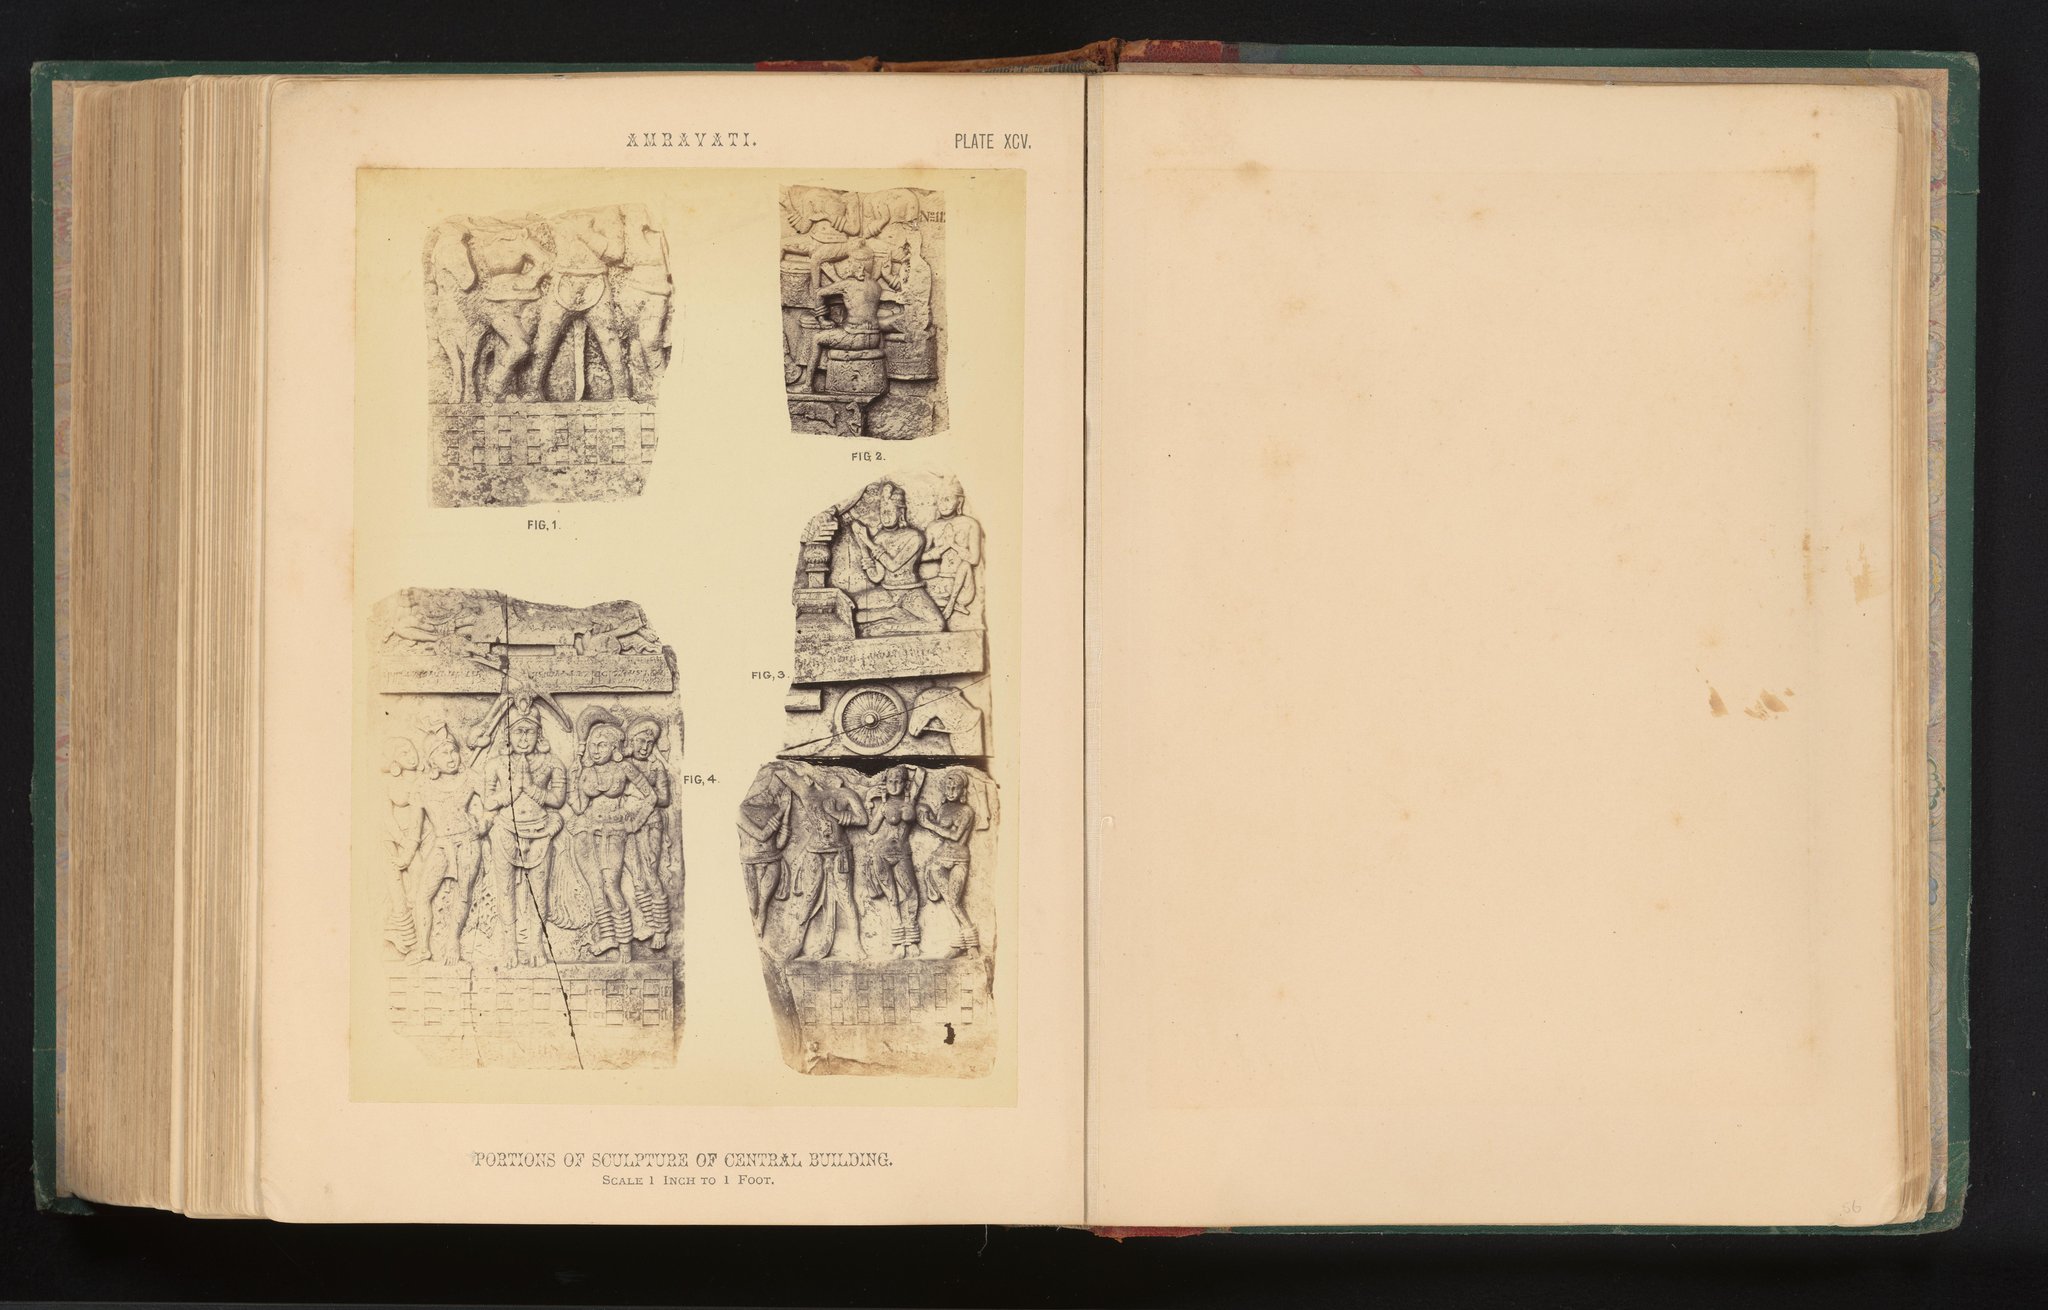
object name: page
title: Fragments of sculptures, Amaravati, Andhra Pradesh, India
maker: william h. griggs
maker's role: printer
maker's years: 1832-1911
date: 1863-1868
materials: photographic support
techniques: albumen print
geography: amaravati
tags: hinduism, buddhism, jainism, sculpture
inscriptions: inscription: ‘PORTIONS OF SCULPTURE OF CENTRAL BUILDING./ SCALE 1 INCH TO 1 FOOT.’, inscription: ‘AMRAVATI. PLATE XCV.’